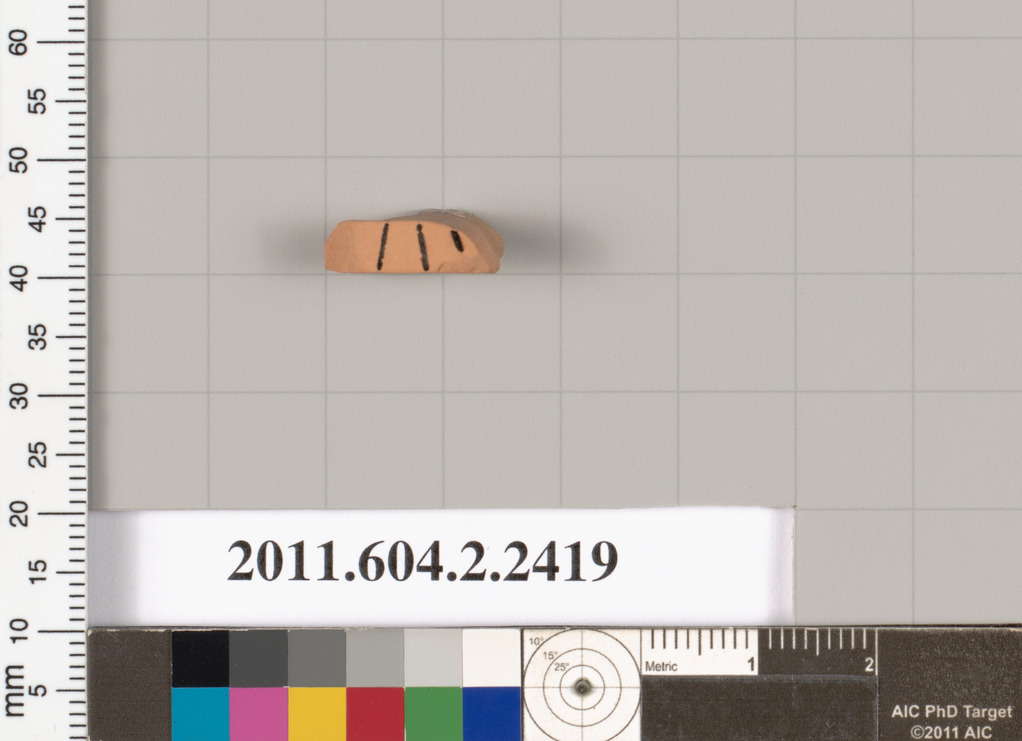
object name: undetermined shape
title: Terracotta fragment of an undetermined shape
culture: greek, attic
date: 490-470 BCE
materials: terracotta